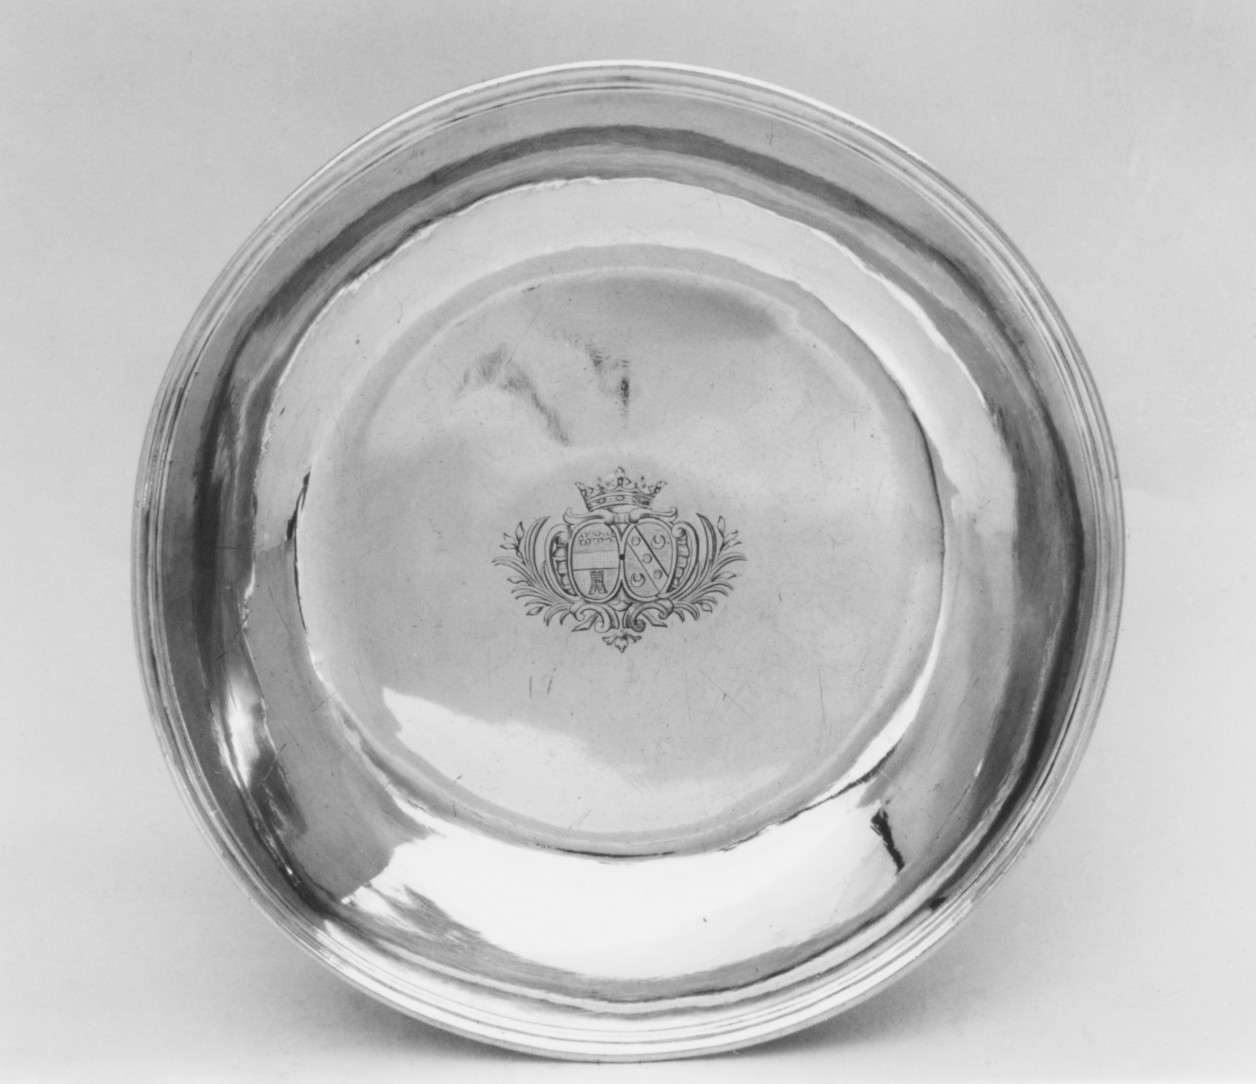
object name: dish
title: Dish (one of a pair)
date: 1697-1704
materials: silver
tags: coat of arms